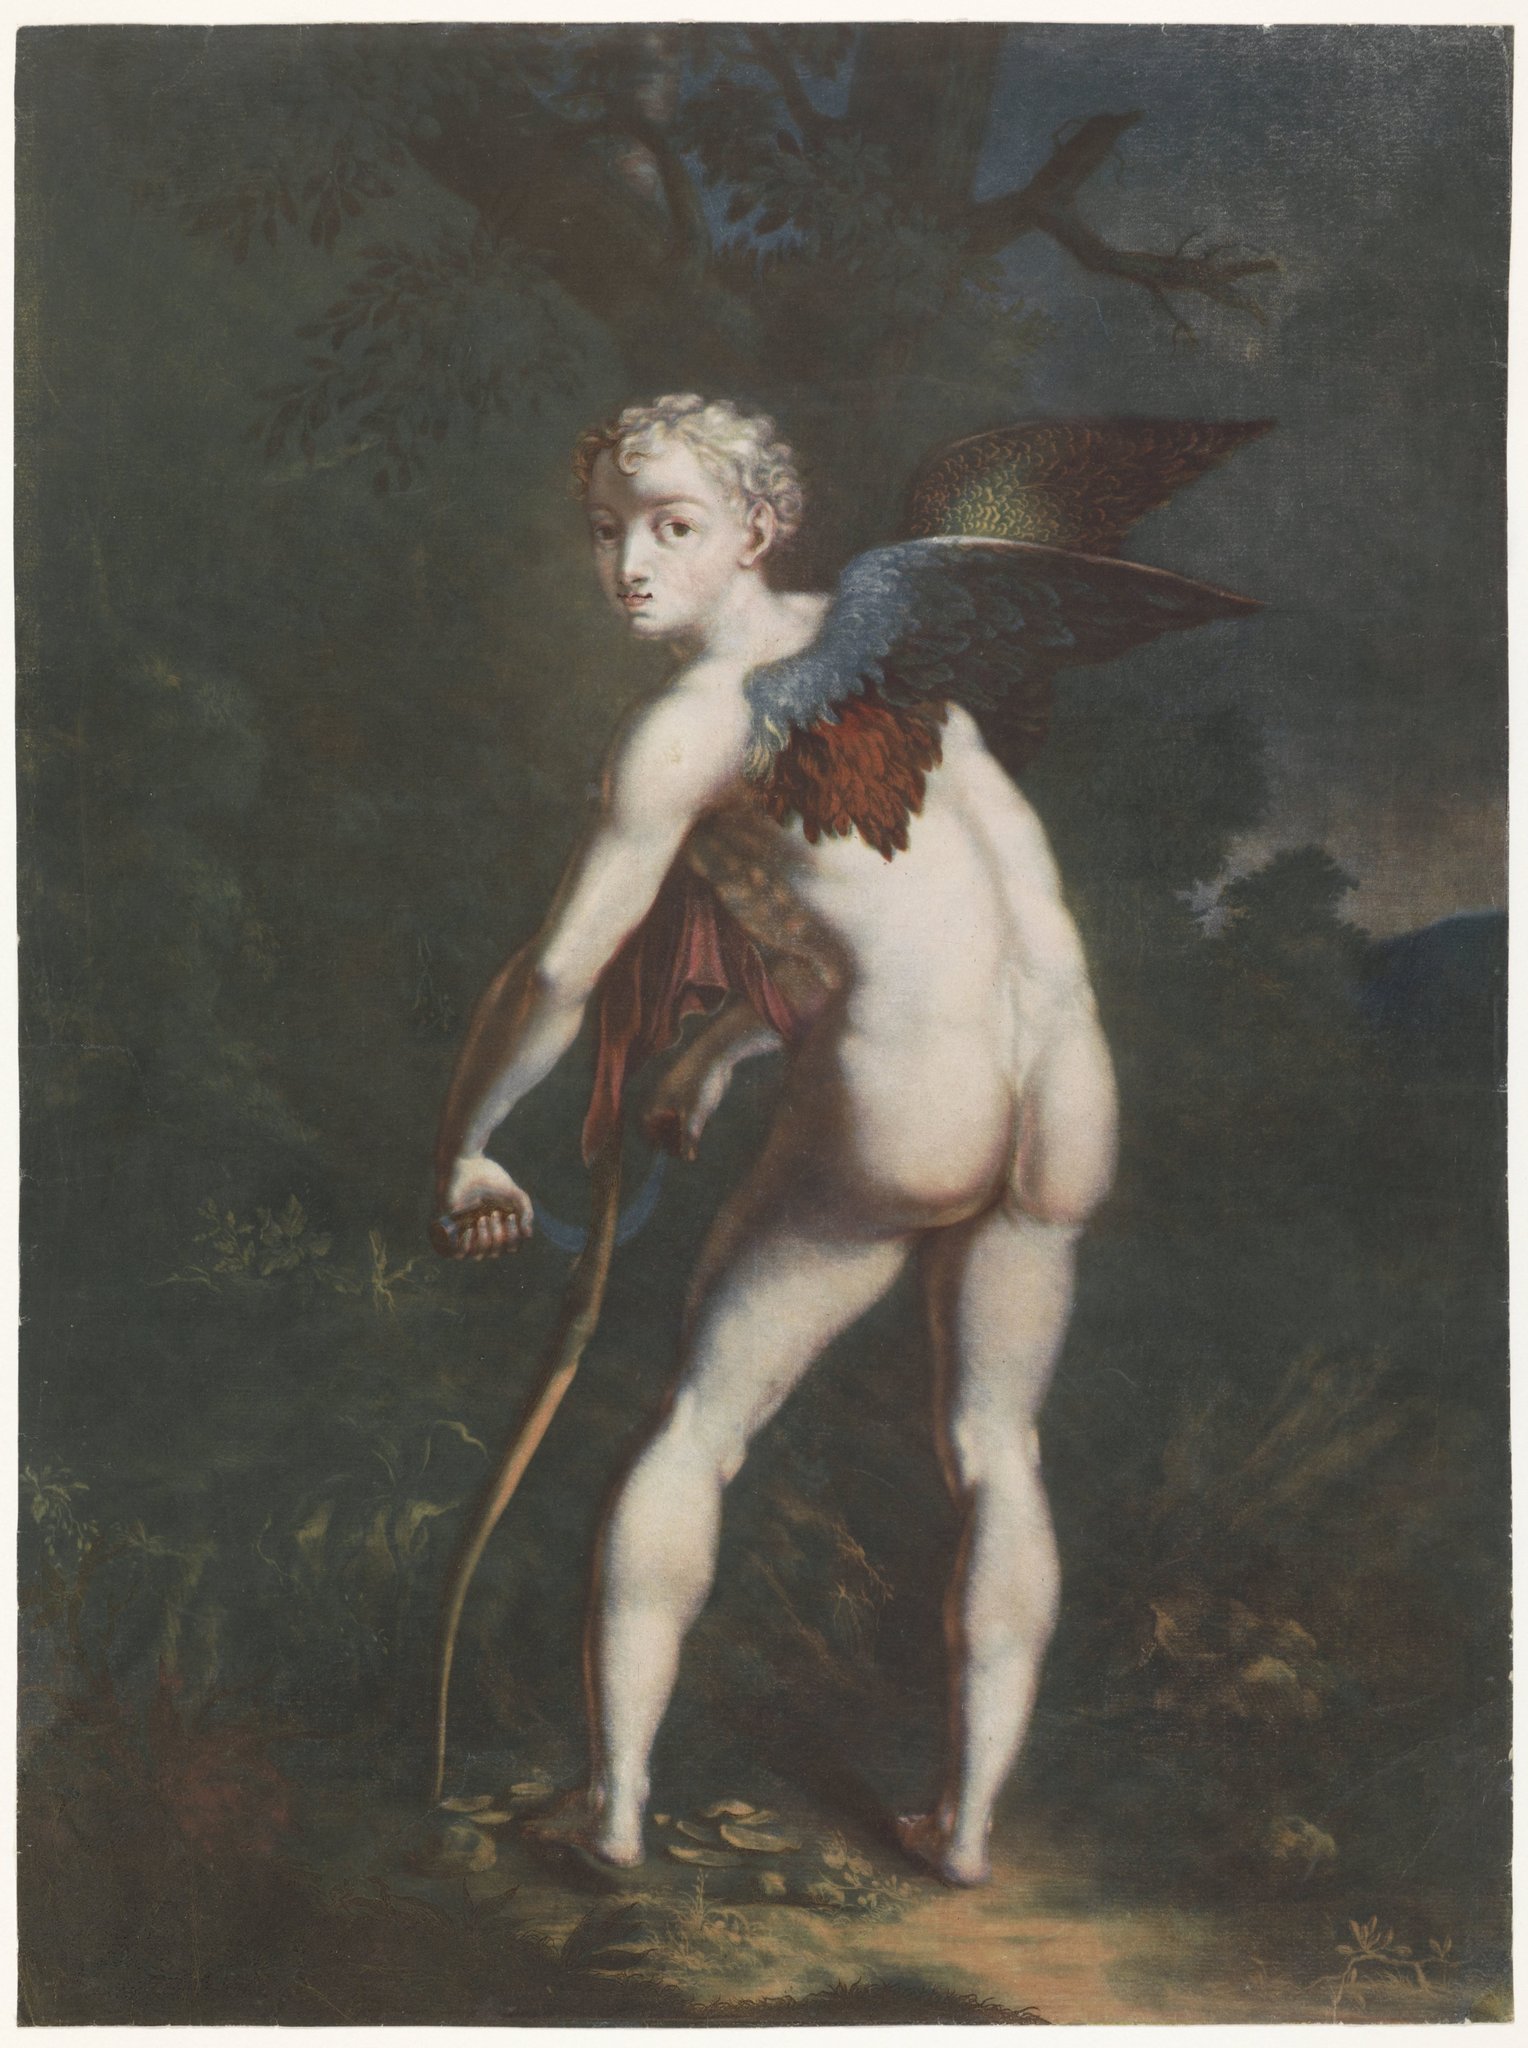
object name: print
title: Amor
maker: jacob christof le blon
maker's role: print maker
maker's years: 1667-1741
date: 1677-1741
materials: paper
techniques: color etching, mezzotint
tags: (story of) cupid, amor (eros)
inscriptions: collector's mark: Lugt 2228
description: Amor staat op een openplek in het bos. Met een sikkel bewerkt hij zijn boog.